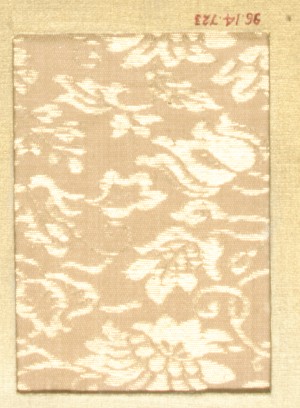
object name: piece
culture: japanese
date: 1701-1900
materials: silk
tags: flowers